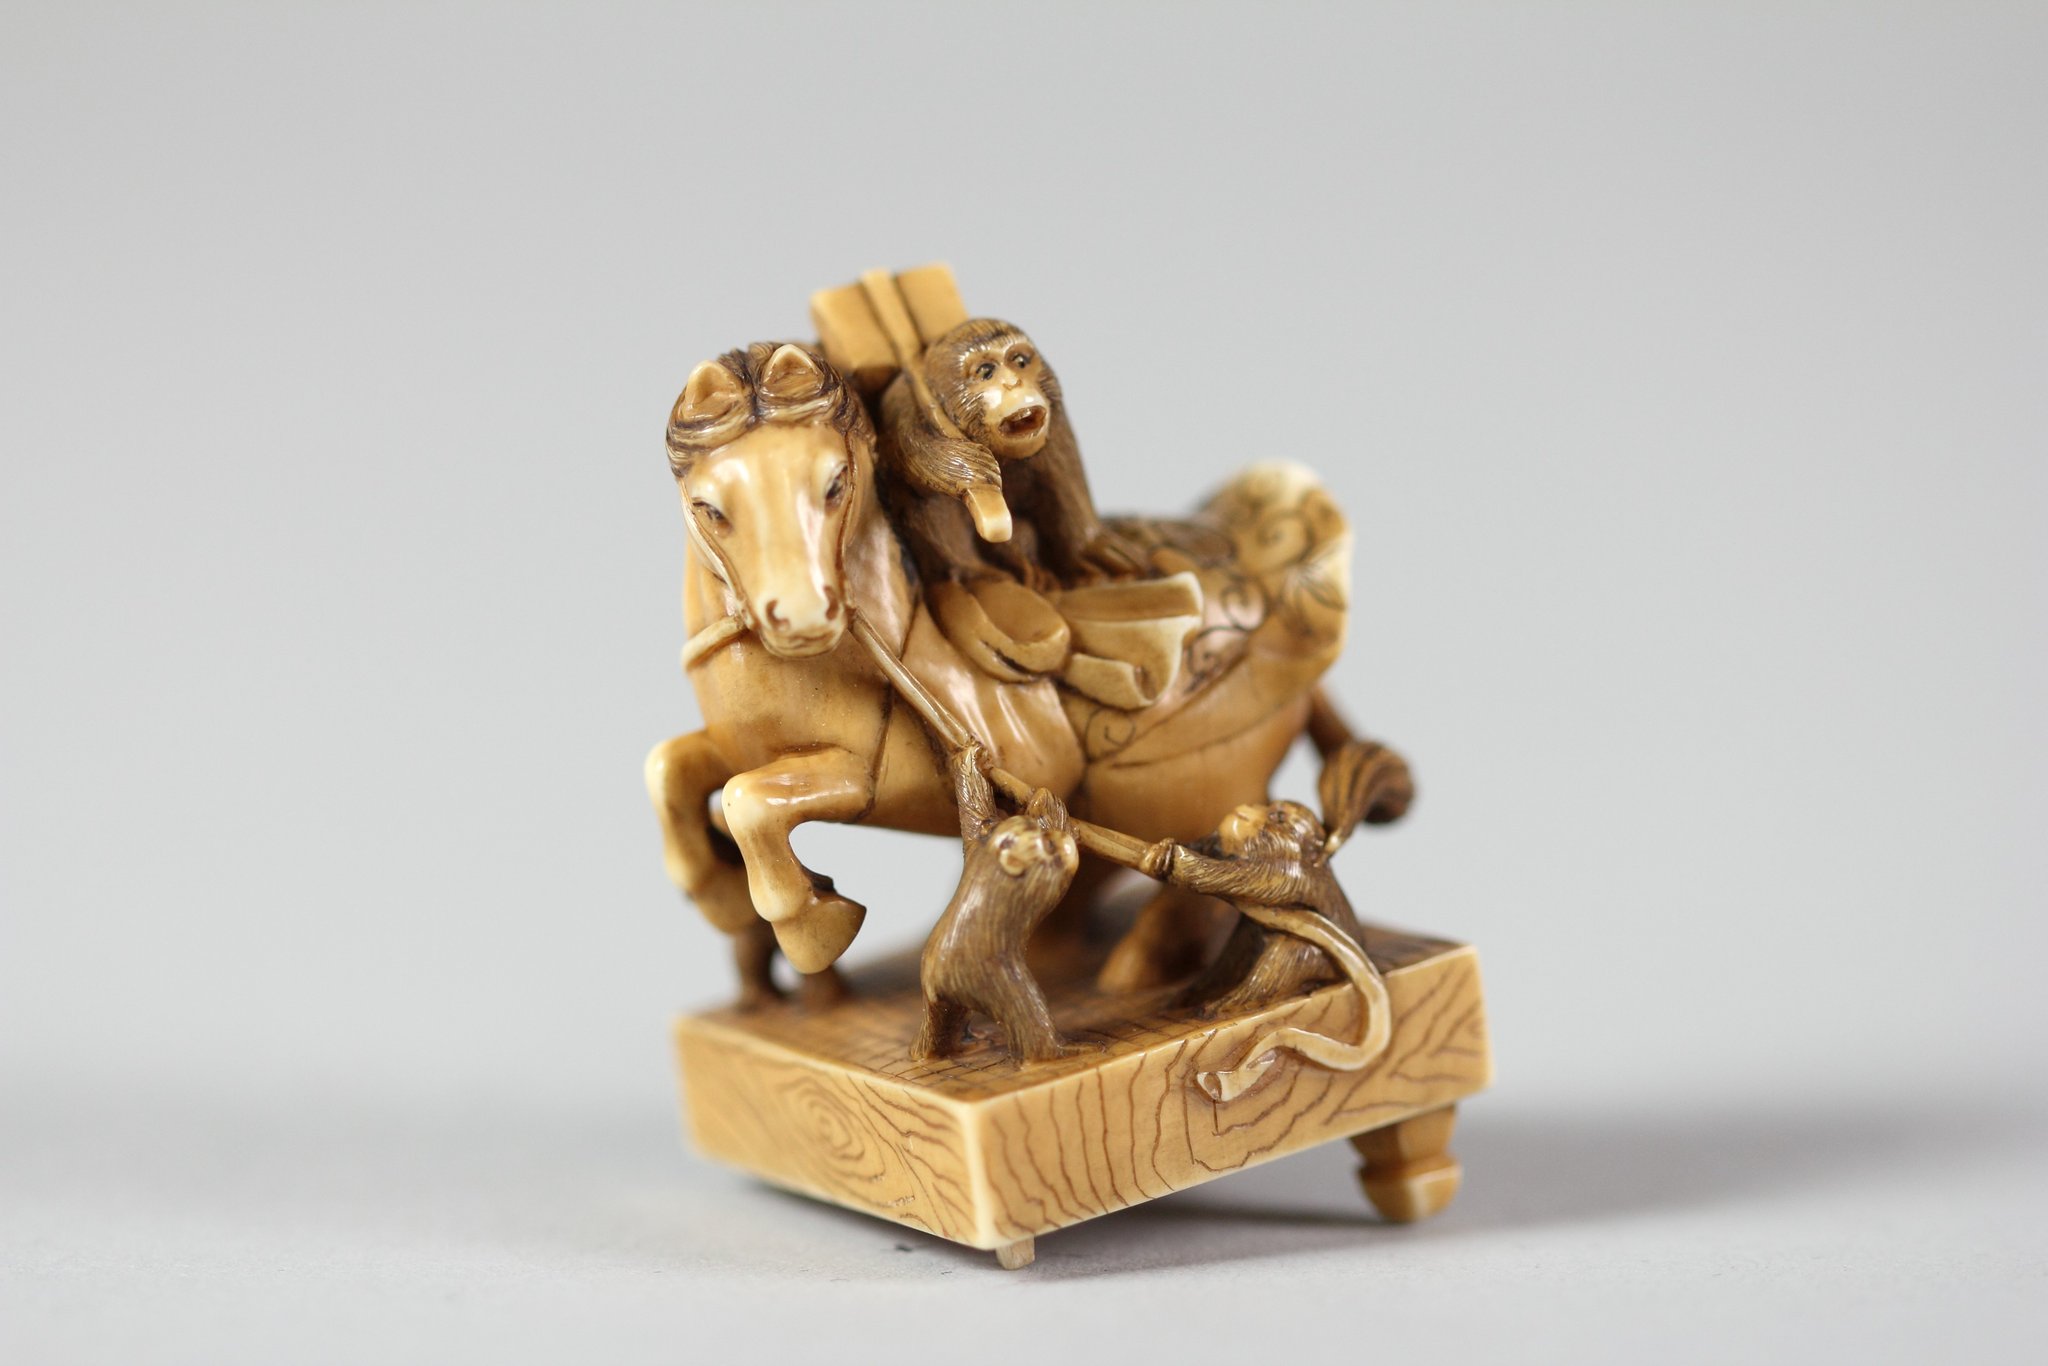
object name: netsuke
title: Netsuke of a Horse on a Pedestal with Monkeys Playing About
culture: japanese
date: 1801-1900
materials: ivory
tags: horses